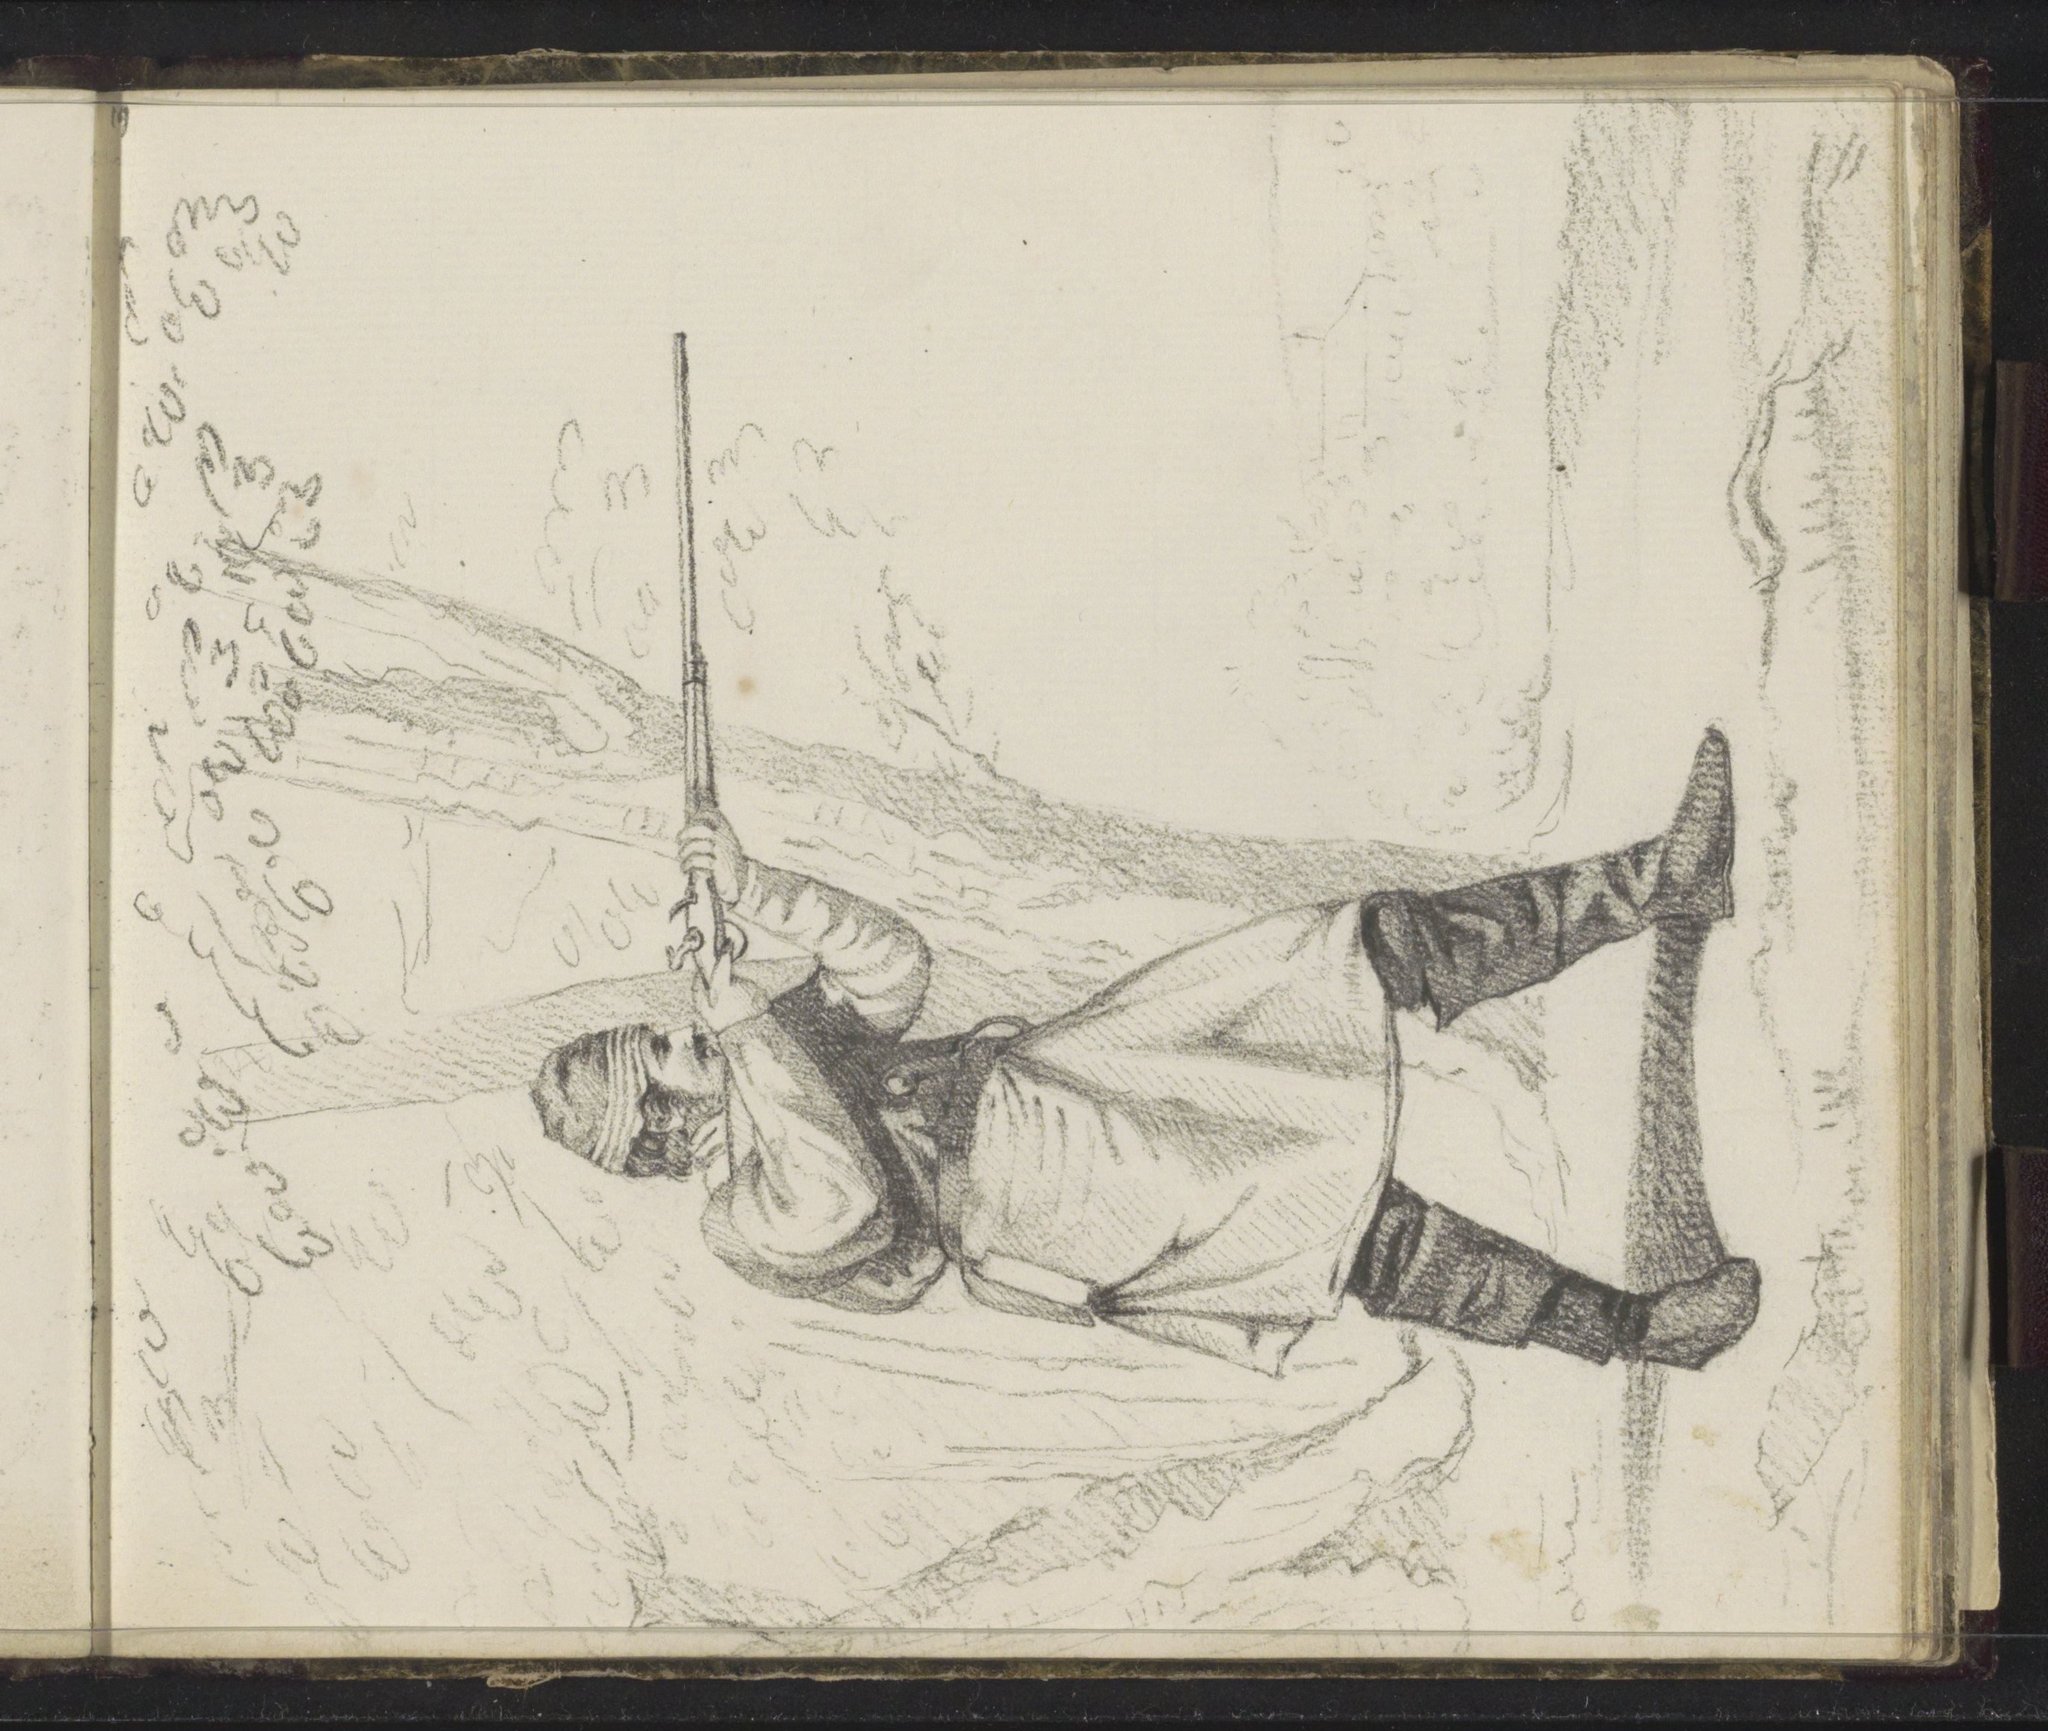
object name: sketchbook leaf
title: Jager met een geweer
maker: hendrik abraham klinkhamer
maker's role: draughtsman, painter, print maker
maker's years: 1810-1872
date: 1820-1872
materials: paper, pencil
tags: hunter, firearms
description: Blad 19 recto uit een schetsboek met 39 bladen.